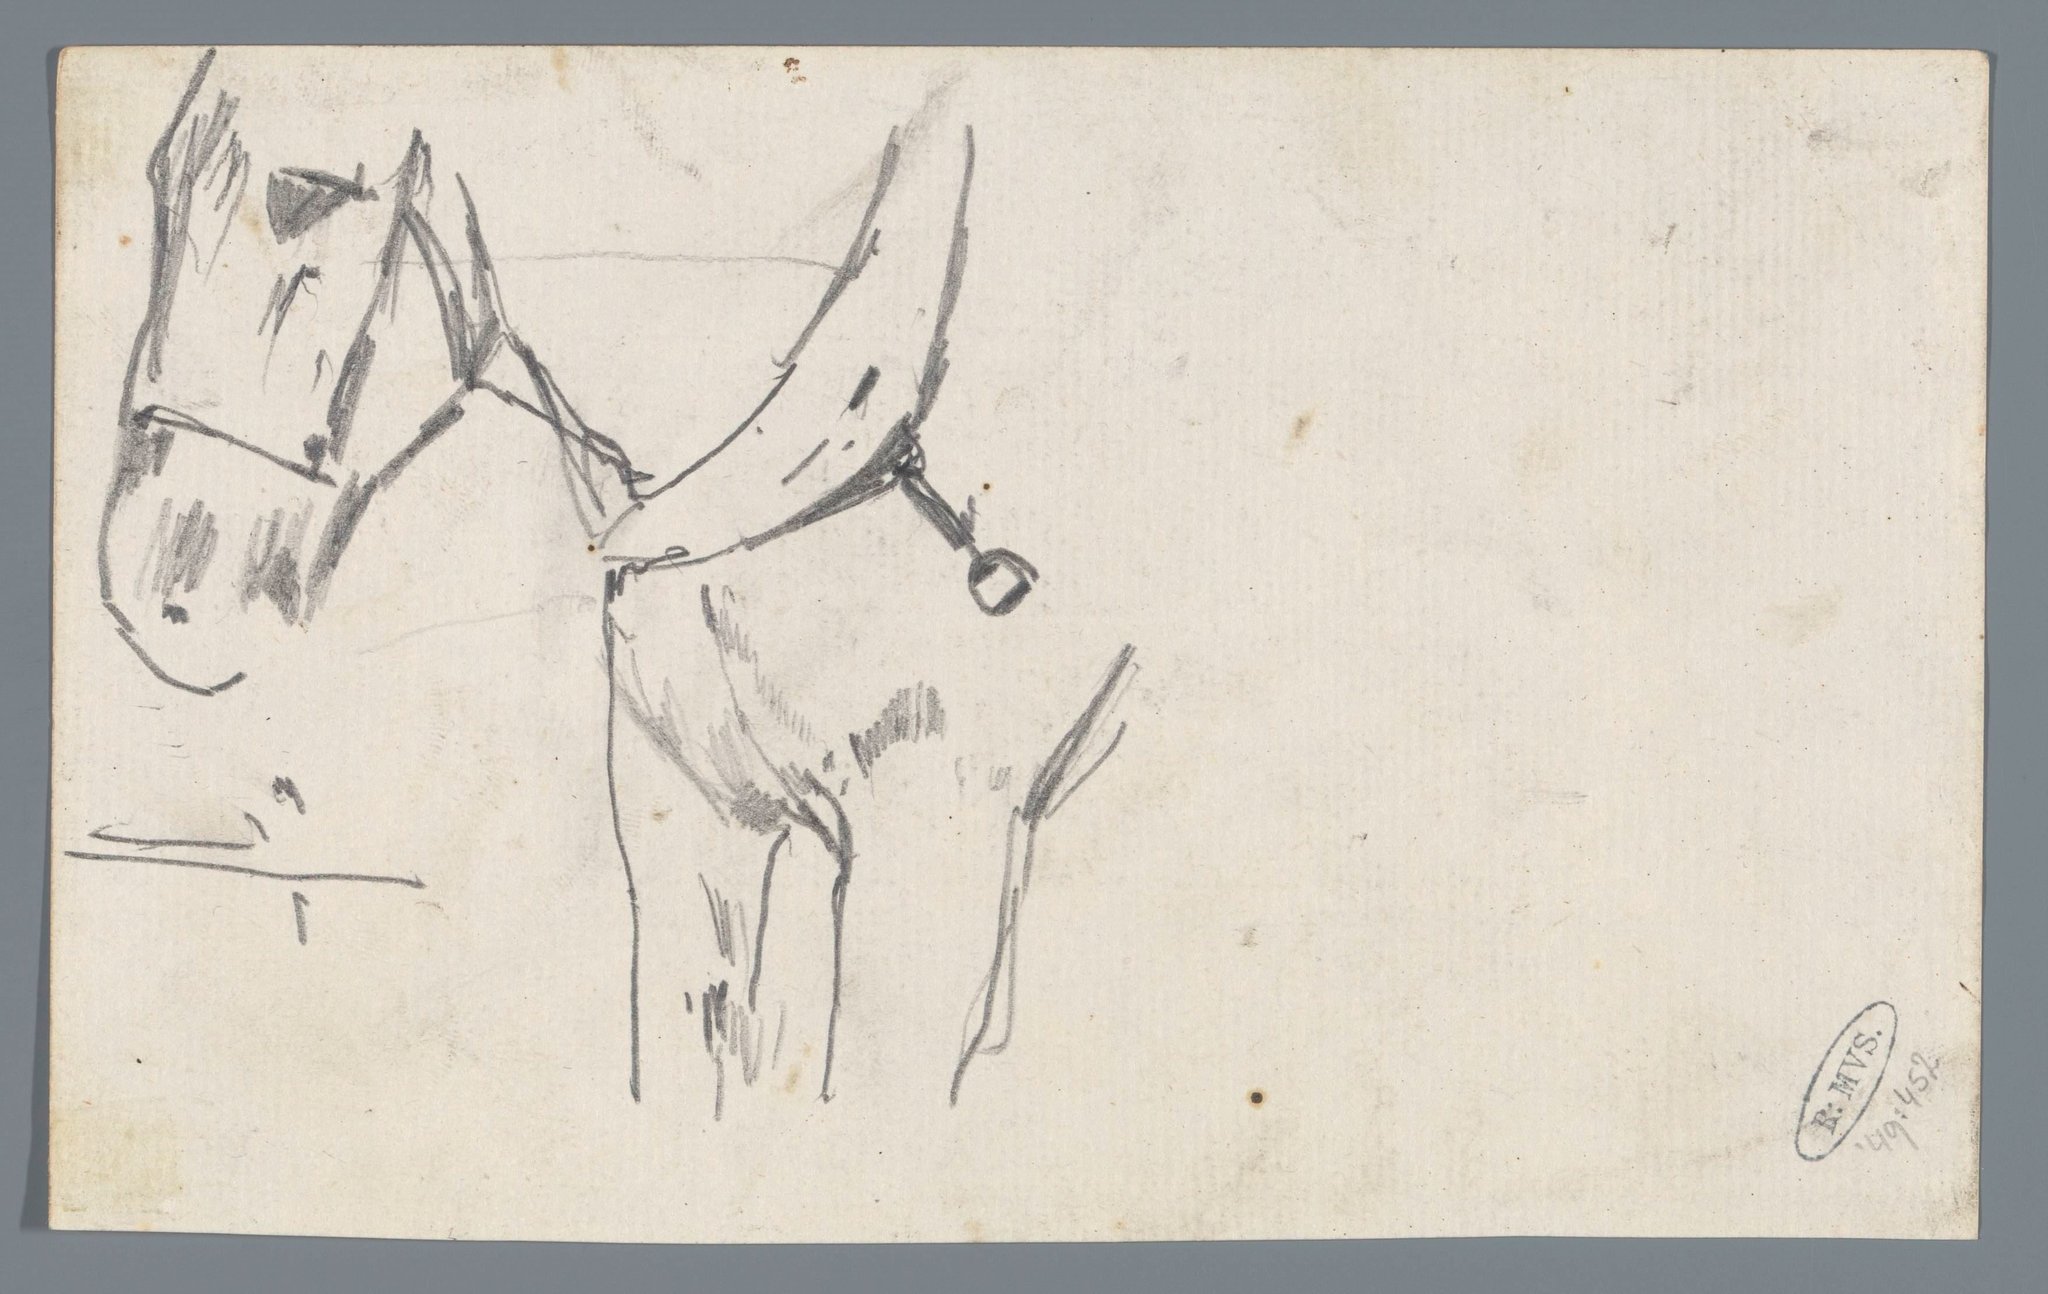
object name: drawing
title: Paard met tuig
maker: george hendrik breitner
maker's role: draughtsman, painter, print maker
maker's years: 1857-1923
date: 1909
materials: paper, pencil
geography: amsterdam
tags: horse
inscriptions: collector's mark: Lugt 2228